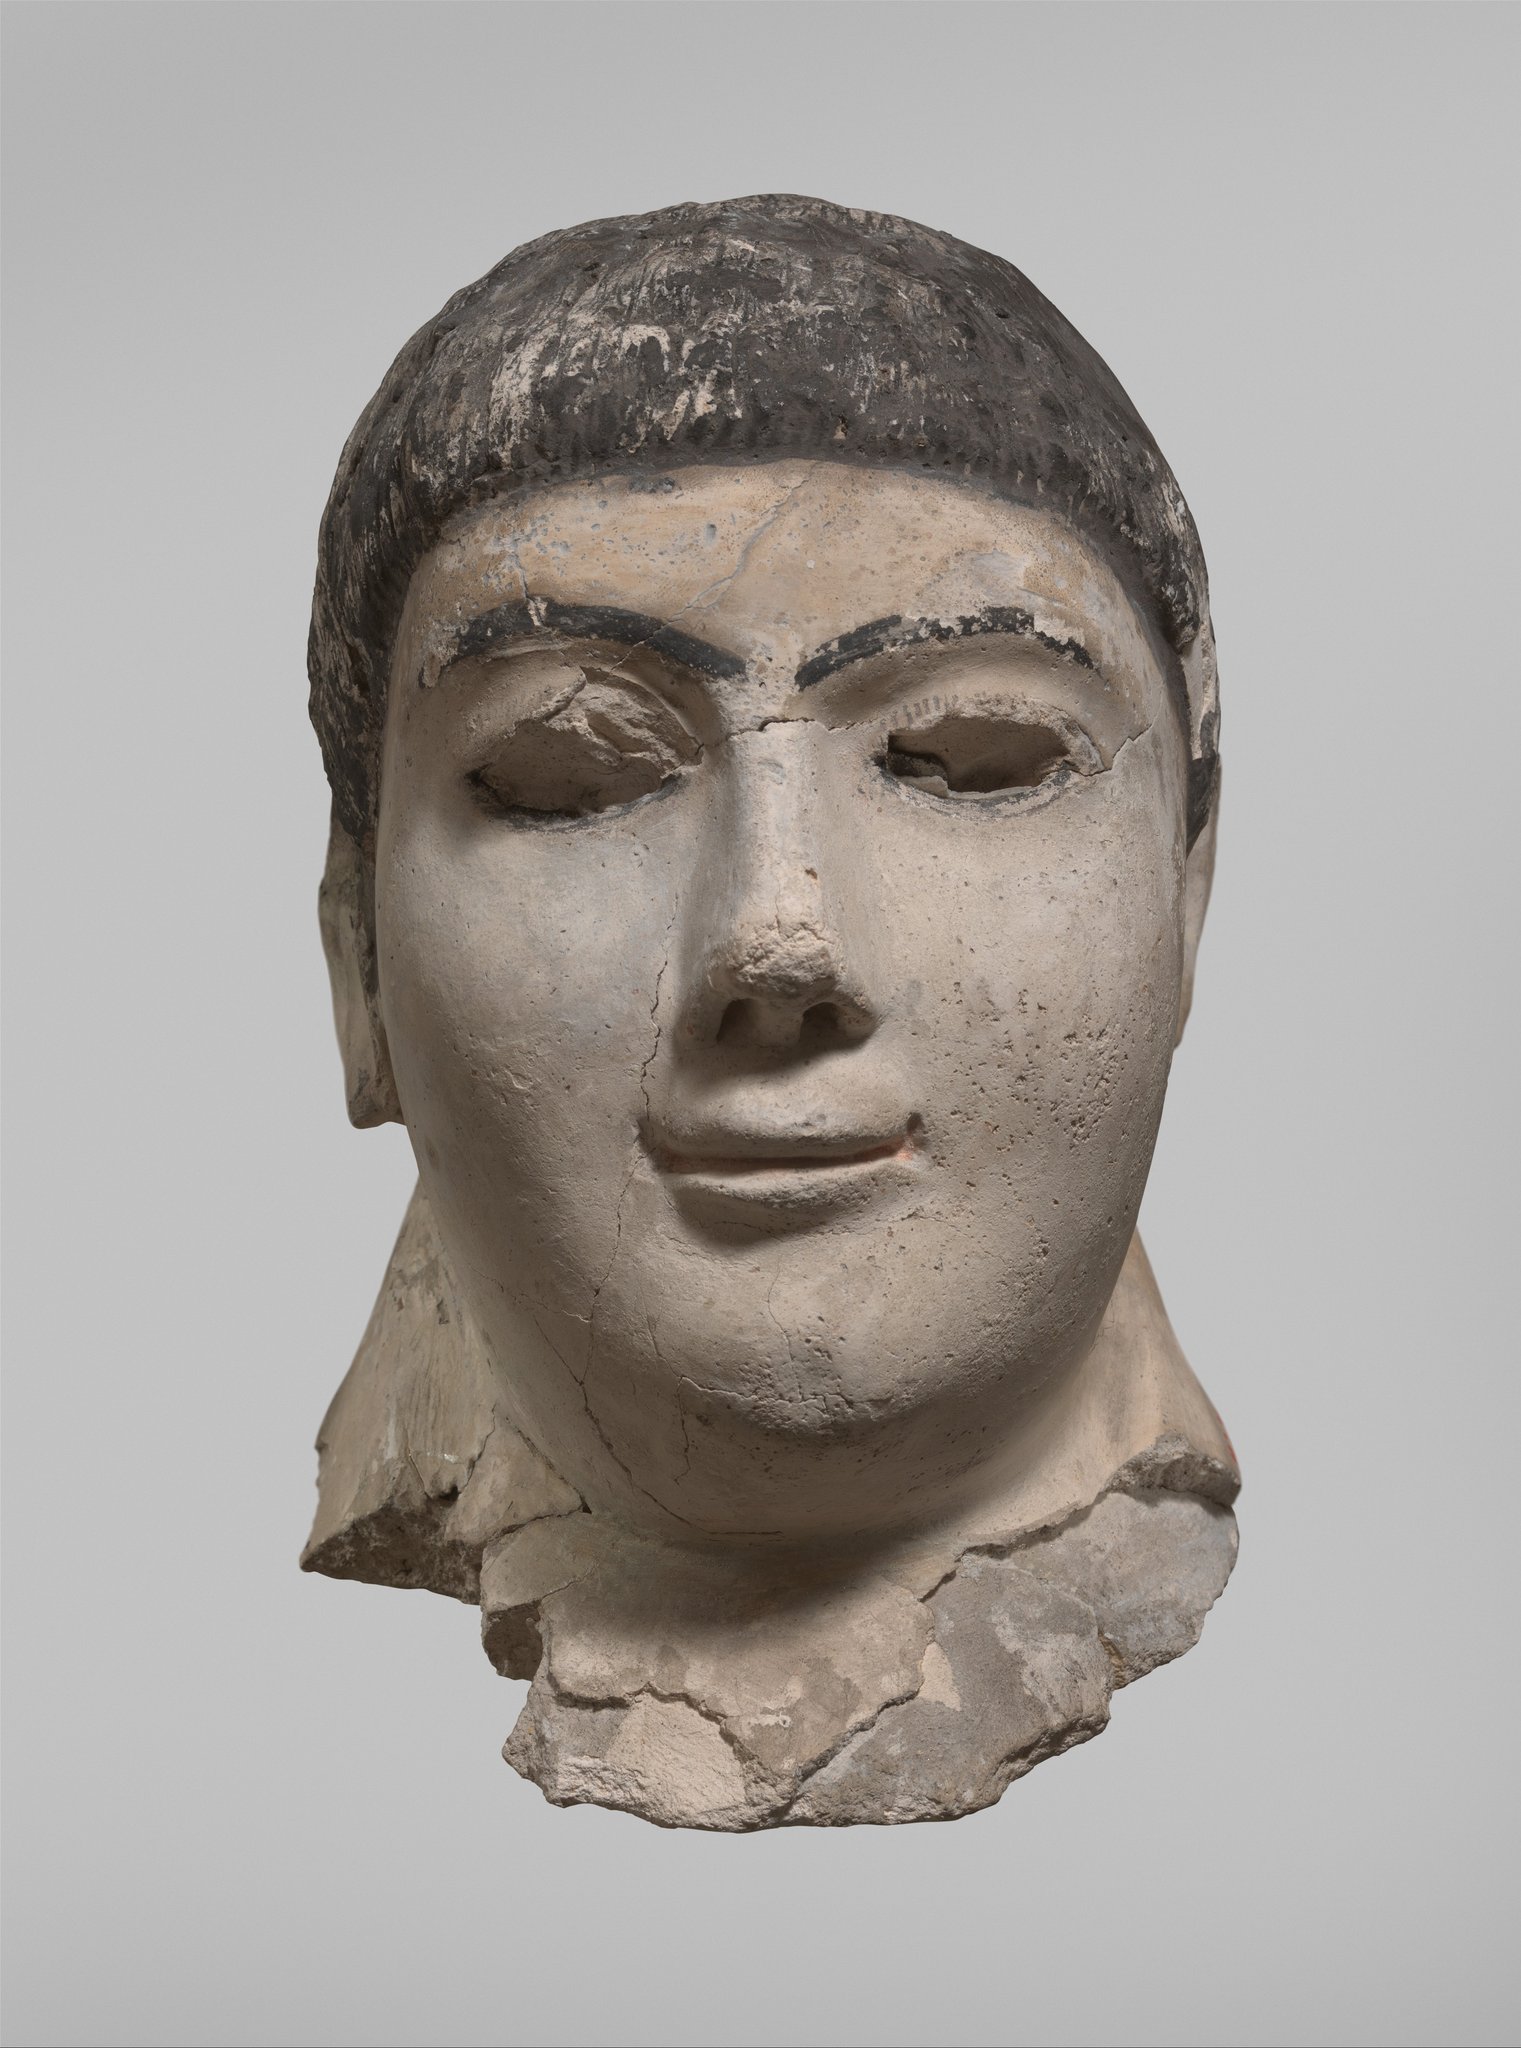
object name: mask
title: Funerary Mask of a woman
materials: paint, plaster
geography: egypt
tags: masks,women